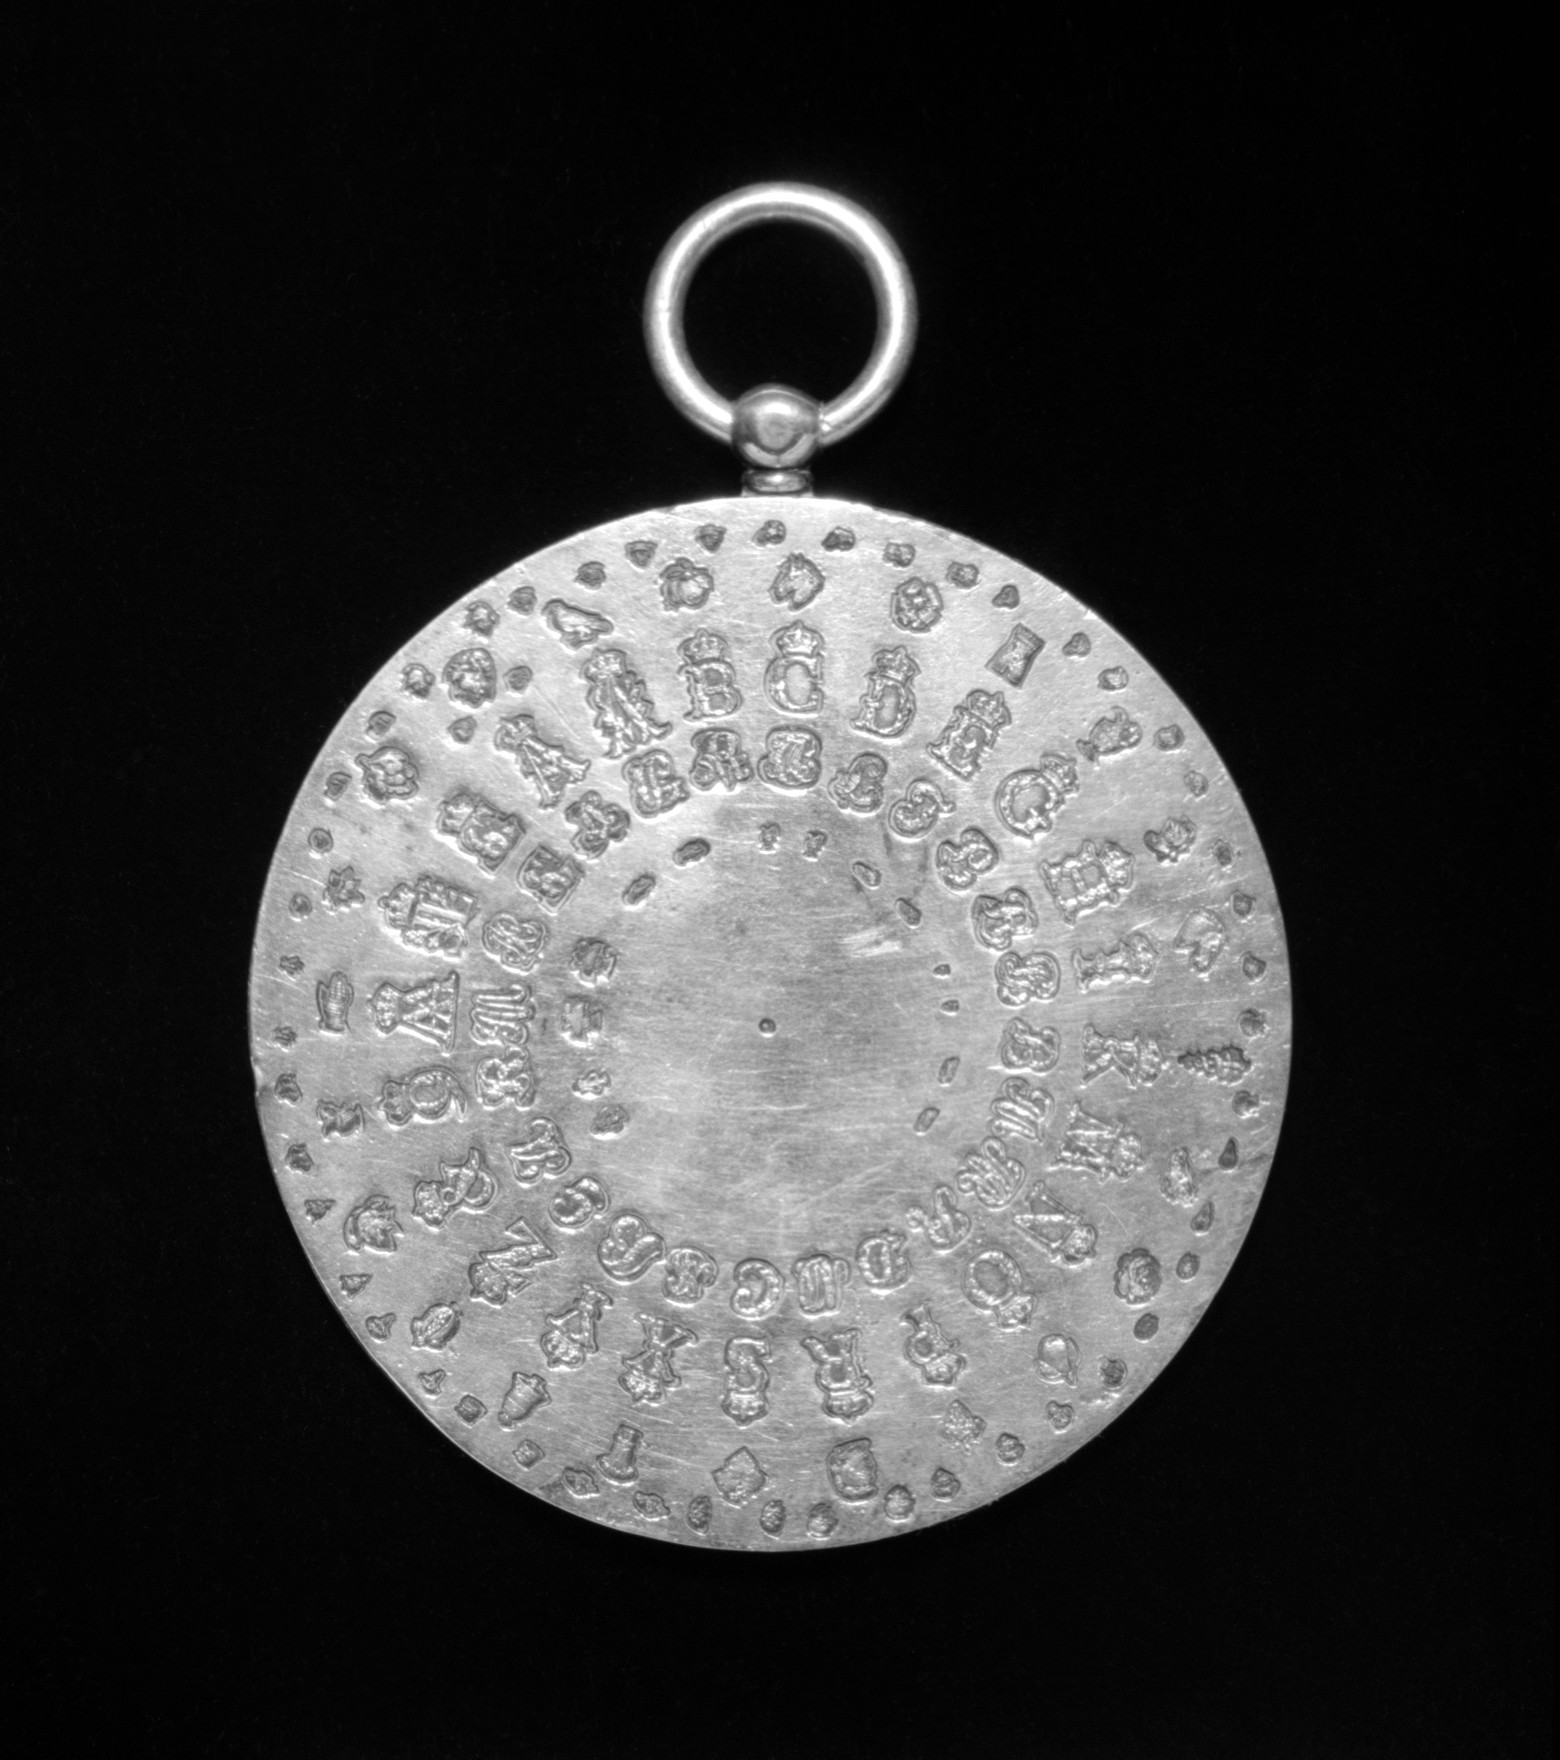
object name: record plaque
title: Record plaque (Plaque d'Insculpation)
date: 1781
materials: silver